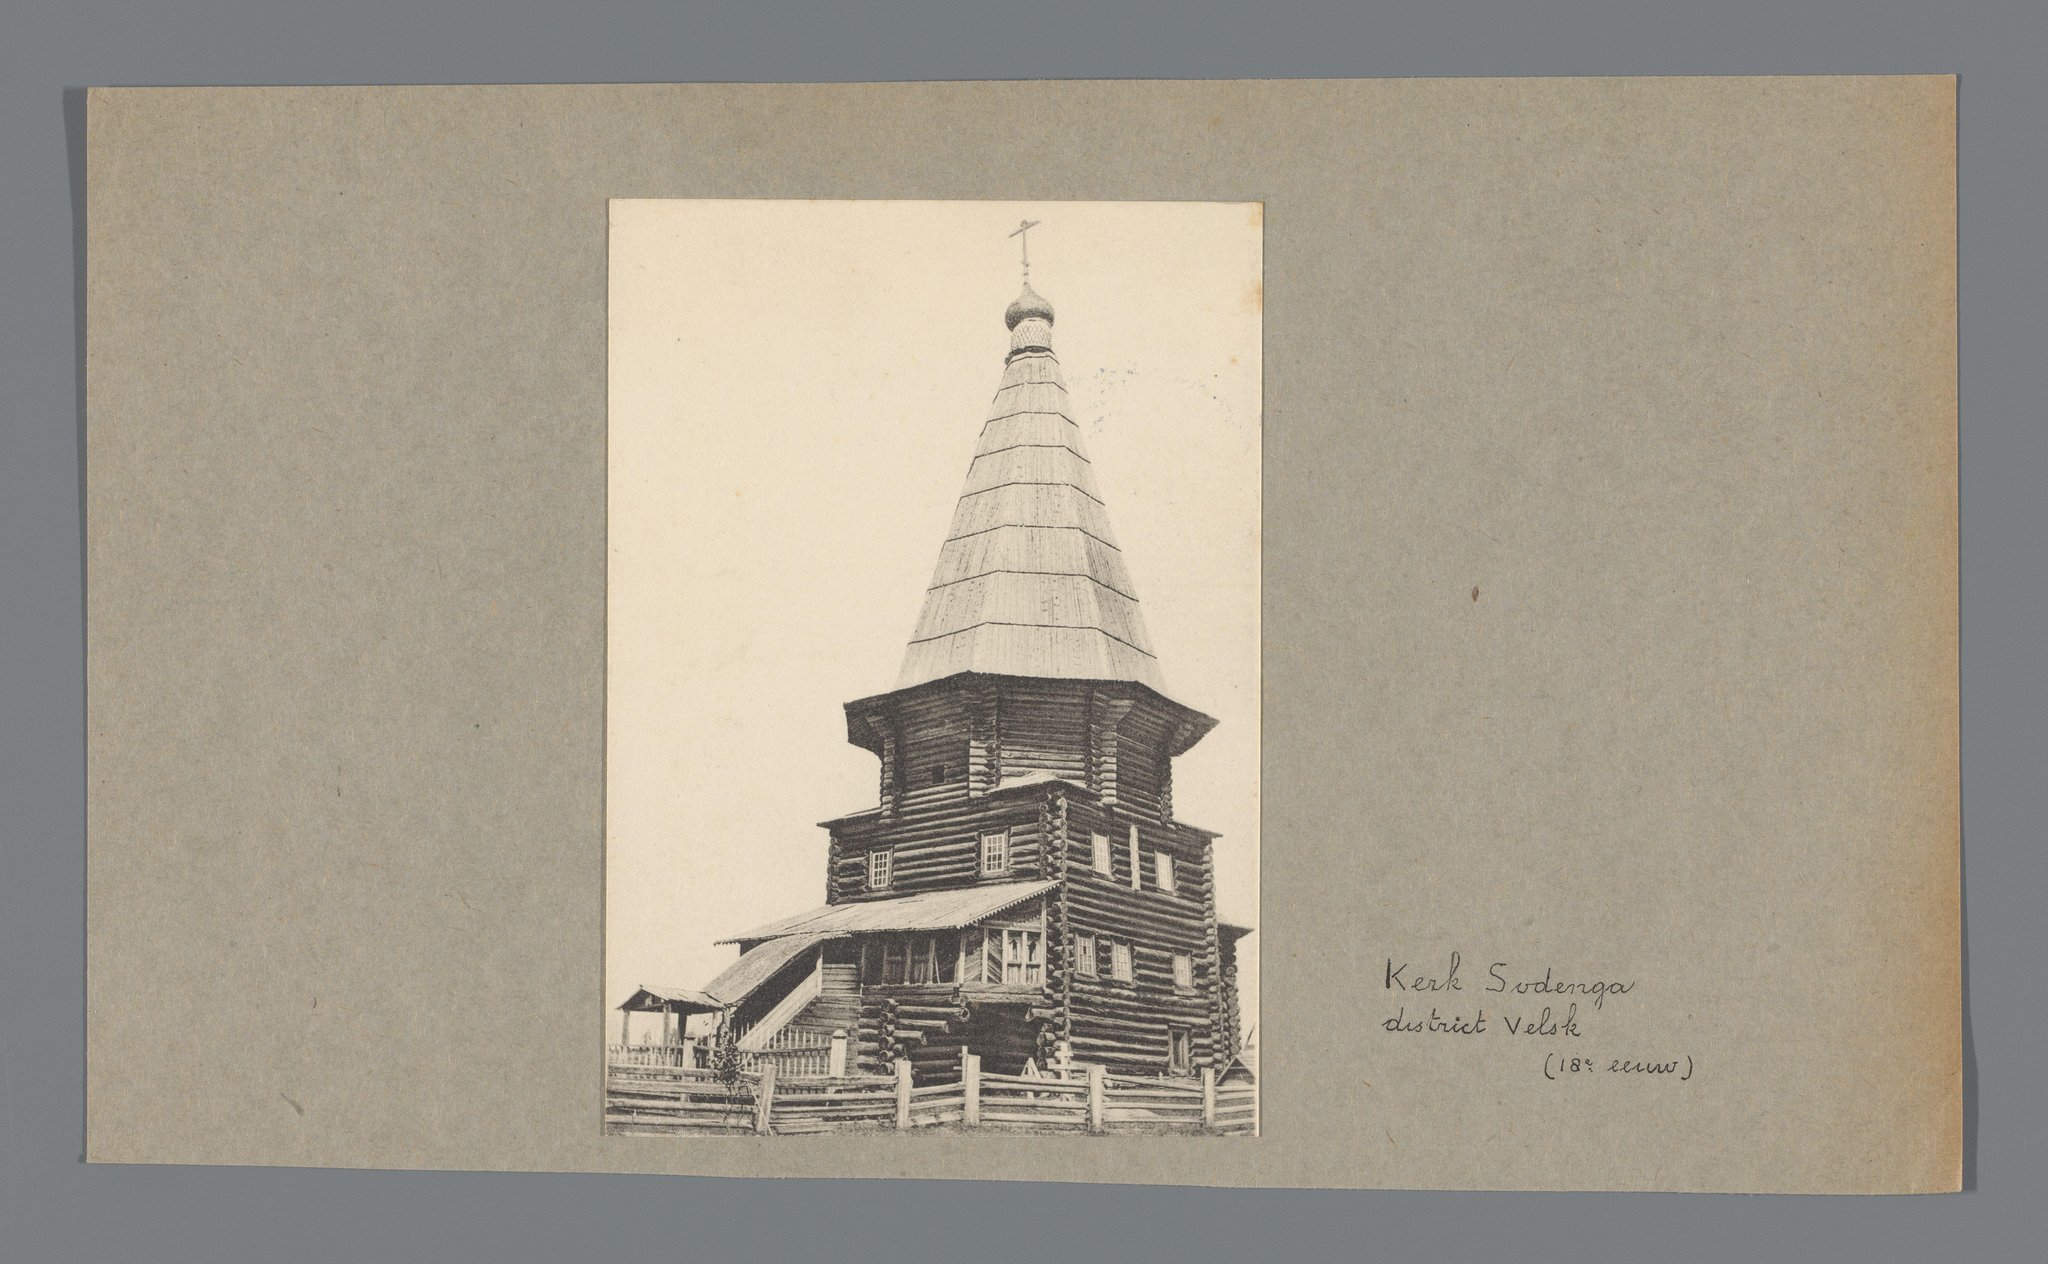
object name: photograph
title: Kerk Sodenga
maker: Anonymous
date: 1860-1925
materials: photographic support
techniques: photograph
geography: russia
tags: russia